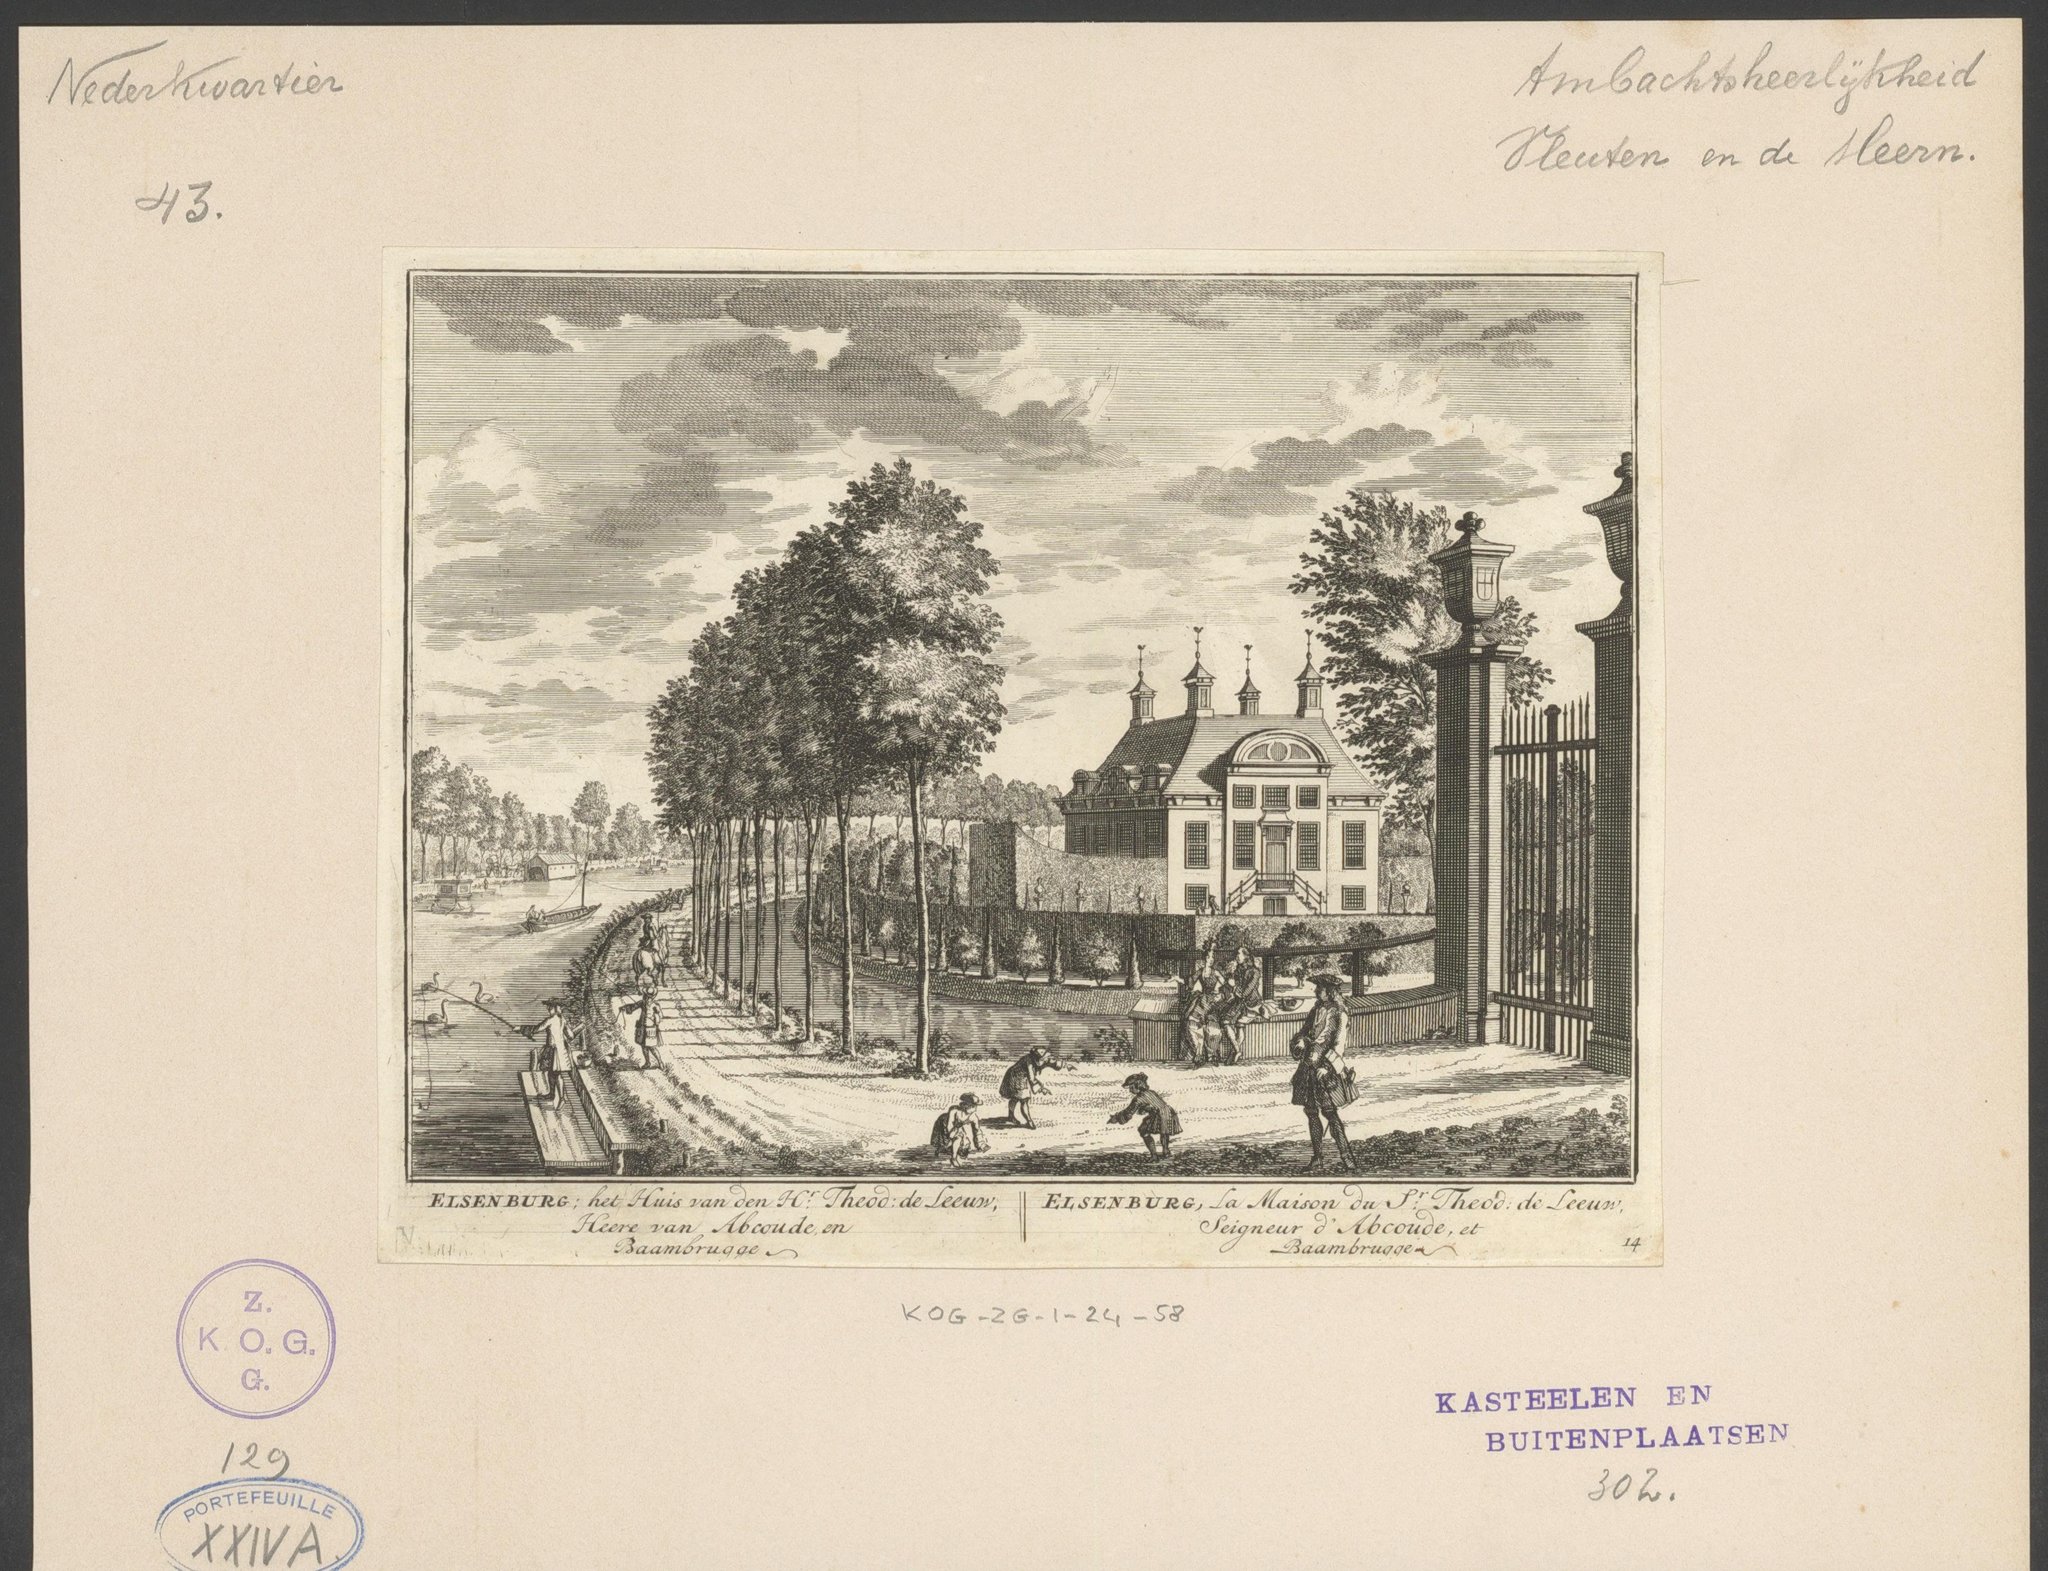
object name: print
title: Elsenburg; het Huis van den H: Theod: de Leeuw, Heere van Abcoude en Baambrugge / Elsenburg, La Maison du S: Theod: de Leeuw, Seigneur d'Abcoude, et Baambrugge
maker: daniël stopendaal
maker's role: print maker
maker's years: 1672-1726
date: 1719-1790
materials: paper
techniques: engraving, etching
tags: river (+ landscape with figures, staffage), country-house, maarssen, vecht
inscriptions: stamp, stamp, collector's mark: Lugt 1641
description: Prent mogelijk uit: Leth, Andries de. De zegepraalende Vecht, vertoonende verscheidene gesichten van lustplaatsen, heeren huysen en dorpen, beginnende van Uitrecht en met Muyden besluytende (...). Amsterdam: Weduwe Nicolaus Visscher, 1719. Of uit: Brouërius van Nidek, Matthaeus. De Vechtstroom, van Utrecht tot Muiden (...). Amsterdam: H. Gartman, W. Vermandel en J.W. Smit, 1790.